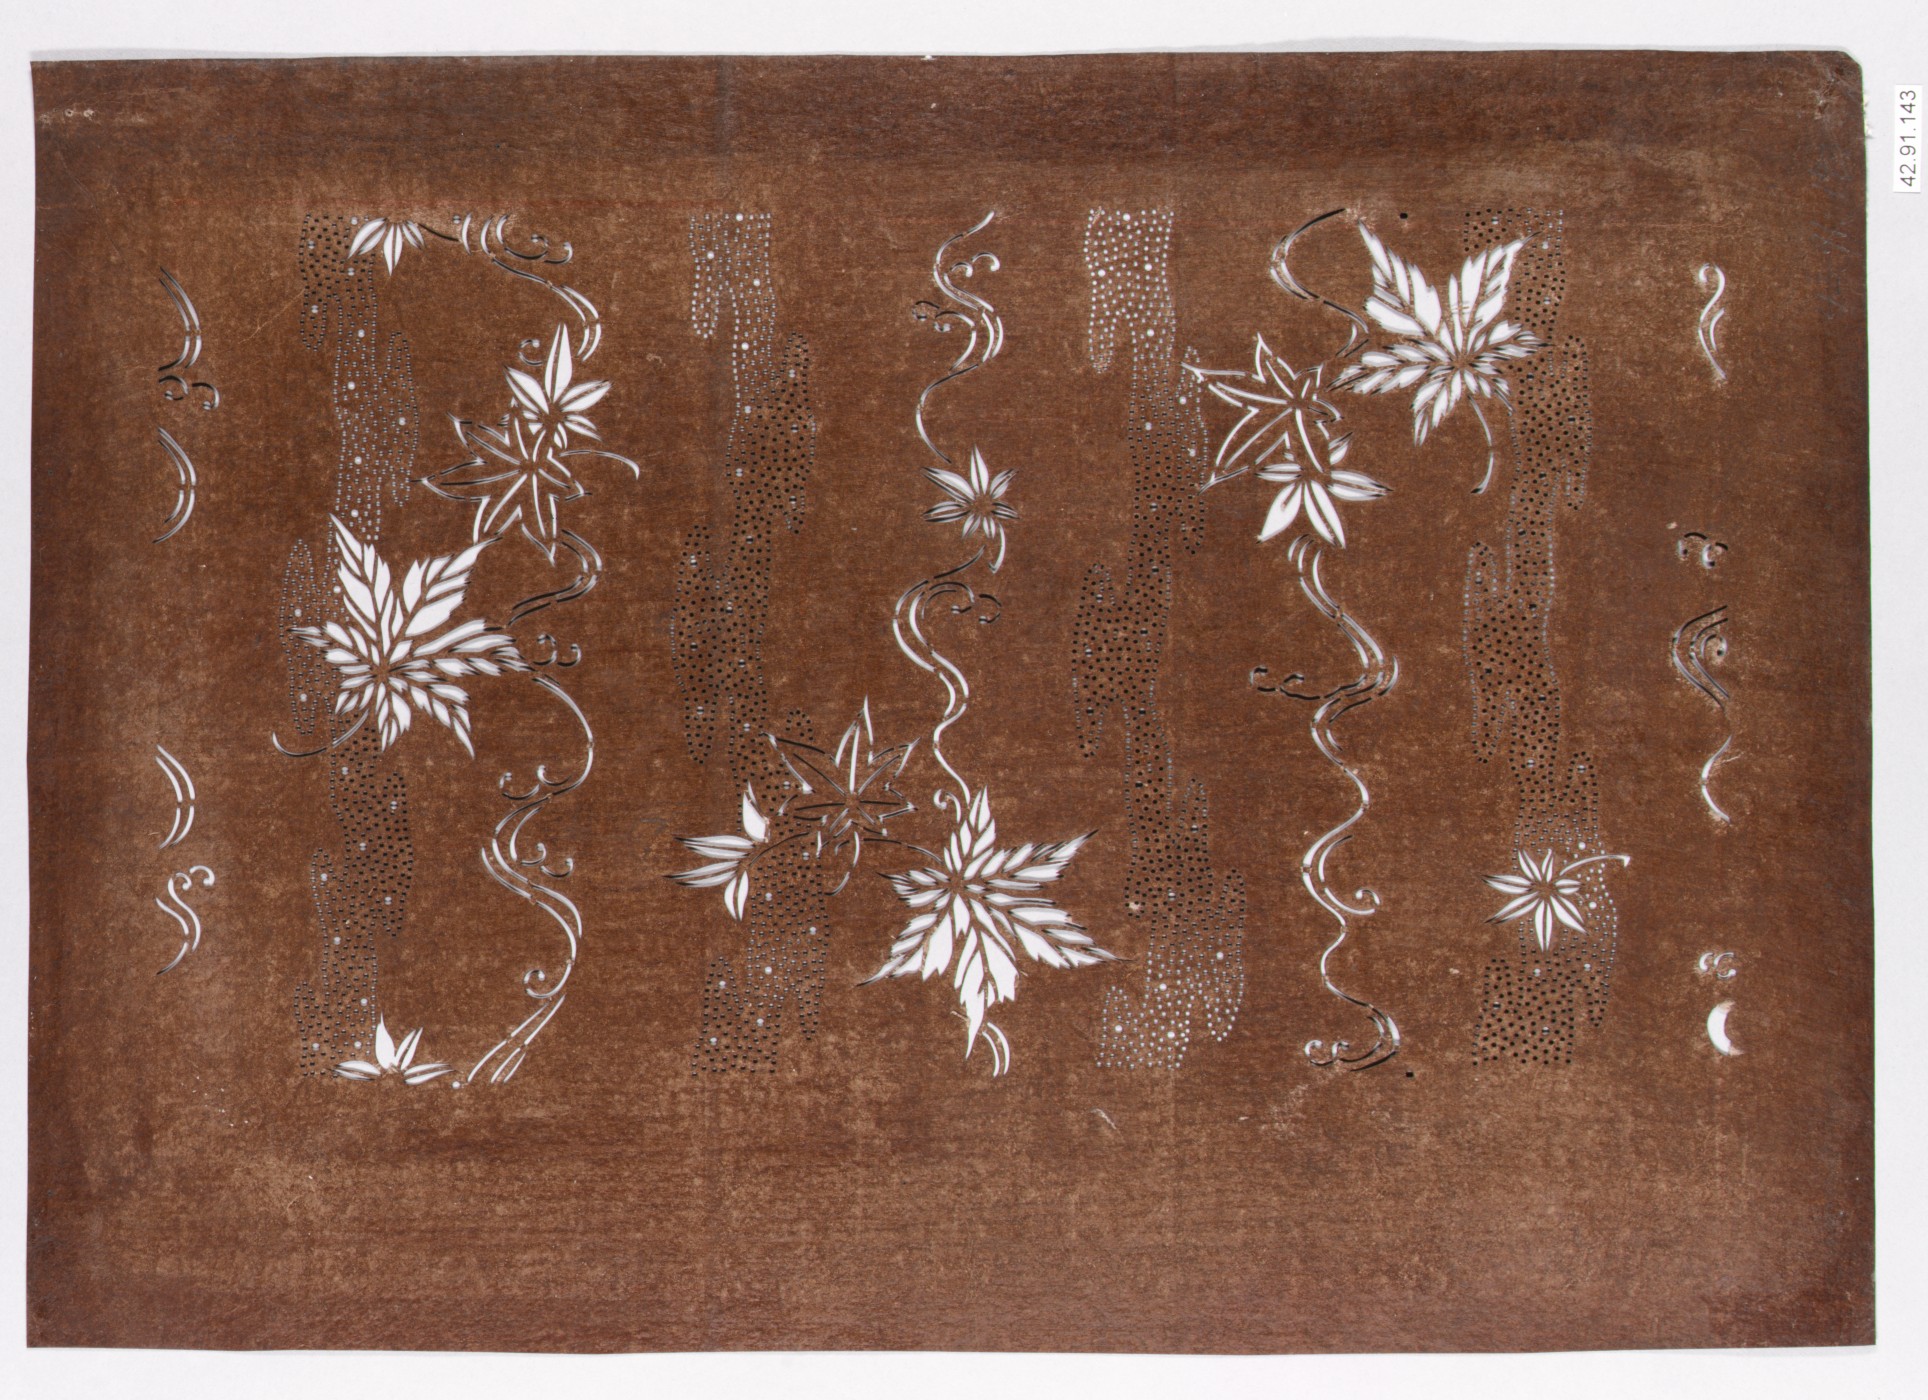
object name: stencil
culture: japanese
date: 1801-1900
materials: paper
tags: leaves